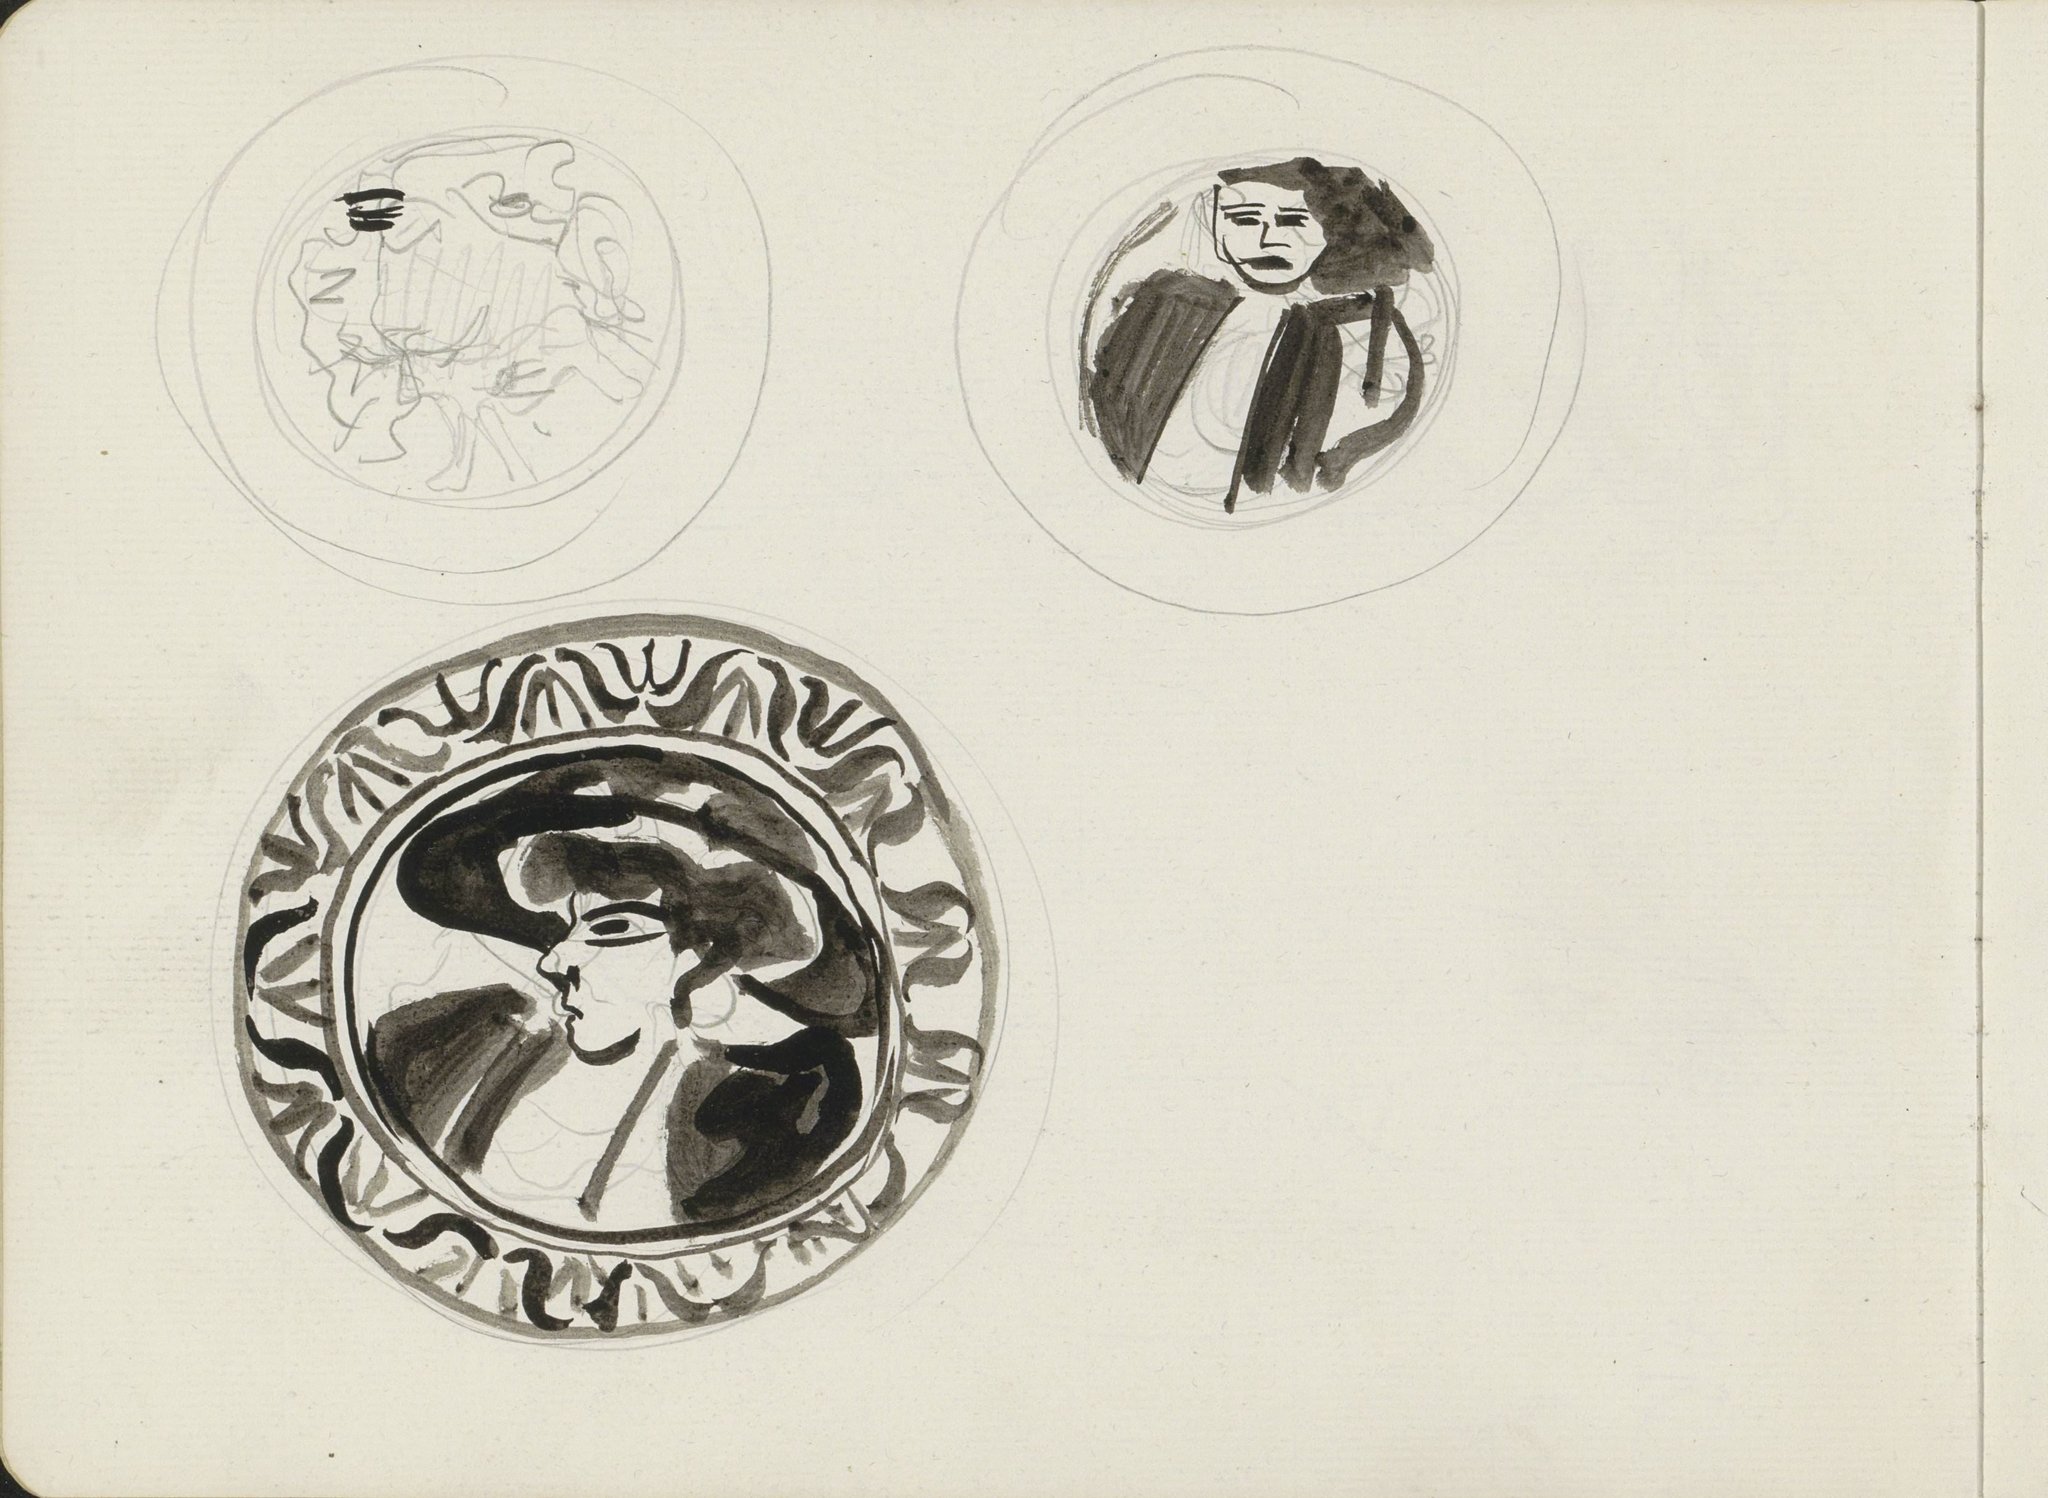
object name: sketchbook leaf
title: Ontwerpen voor een bord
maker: carel adolph lion cachet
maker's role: draughtsman, print maker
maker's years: 1864-1945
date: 1905-1910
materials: ink, paper, pencil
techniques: brush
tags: dish, plate, saucer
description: De rand van het bord heeft een decoratief motief en omsluit een voorstelling van een vrouw. Blad 7 verso uit een schetsboek met 27 bladen.